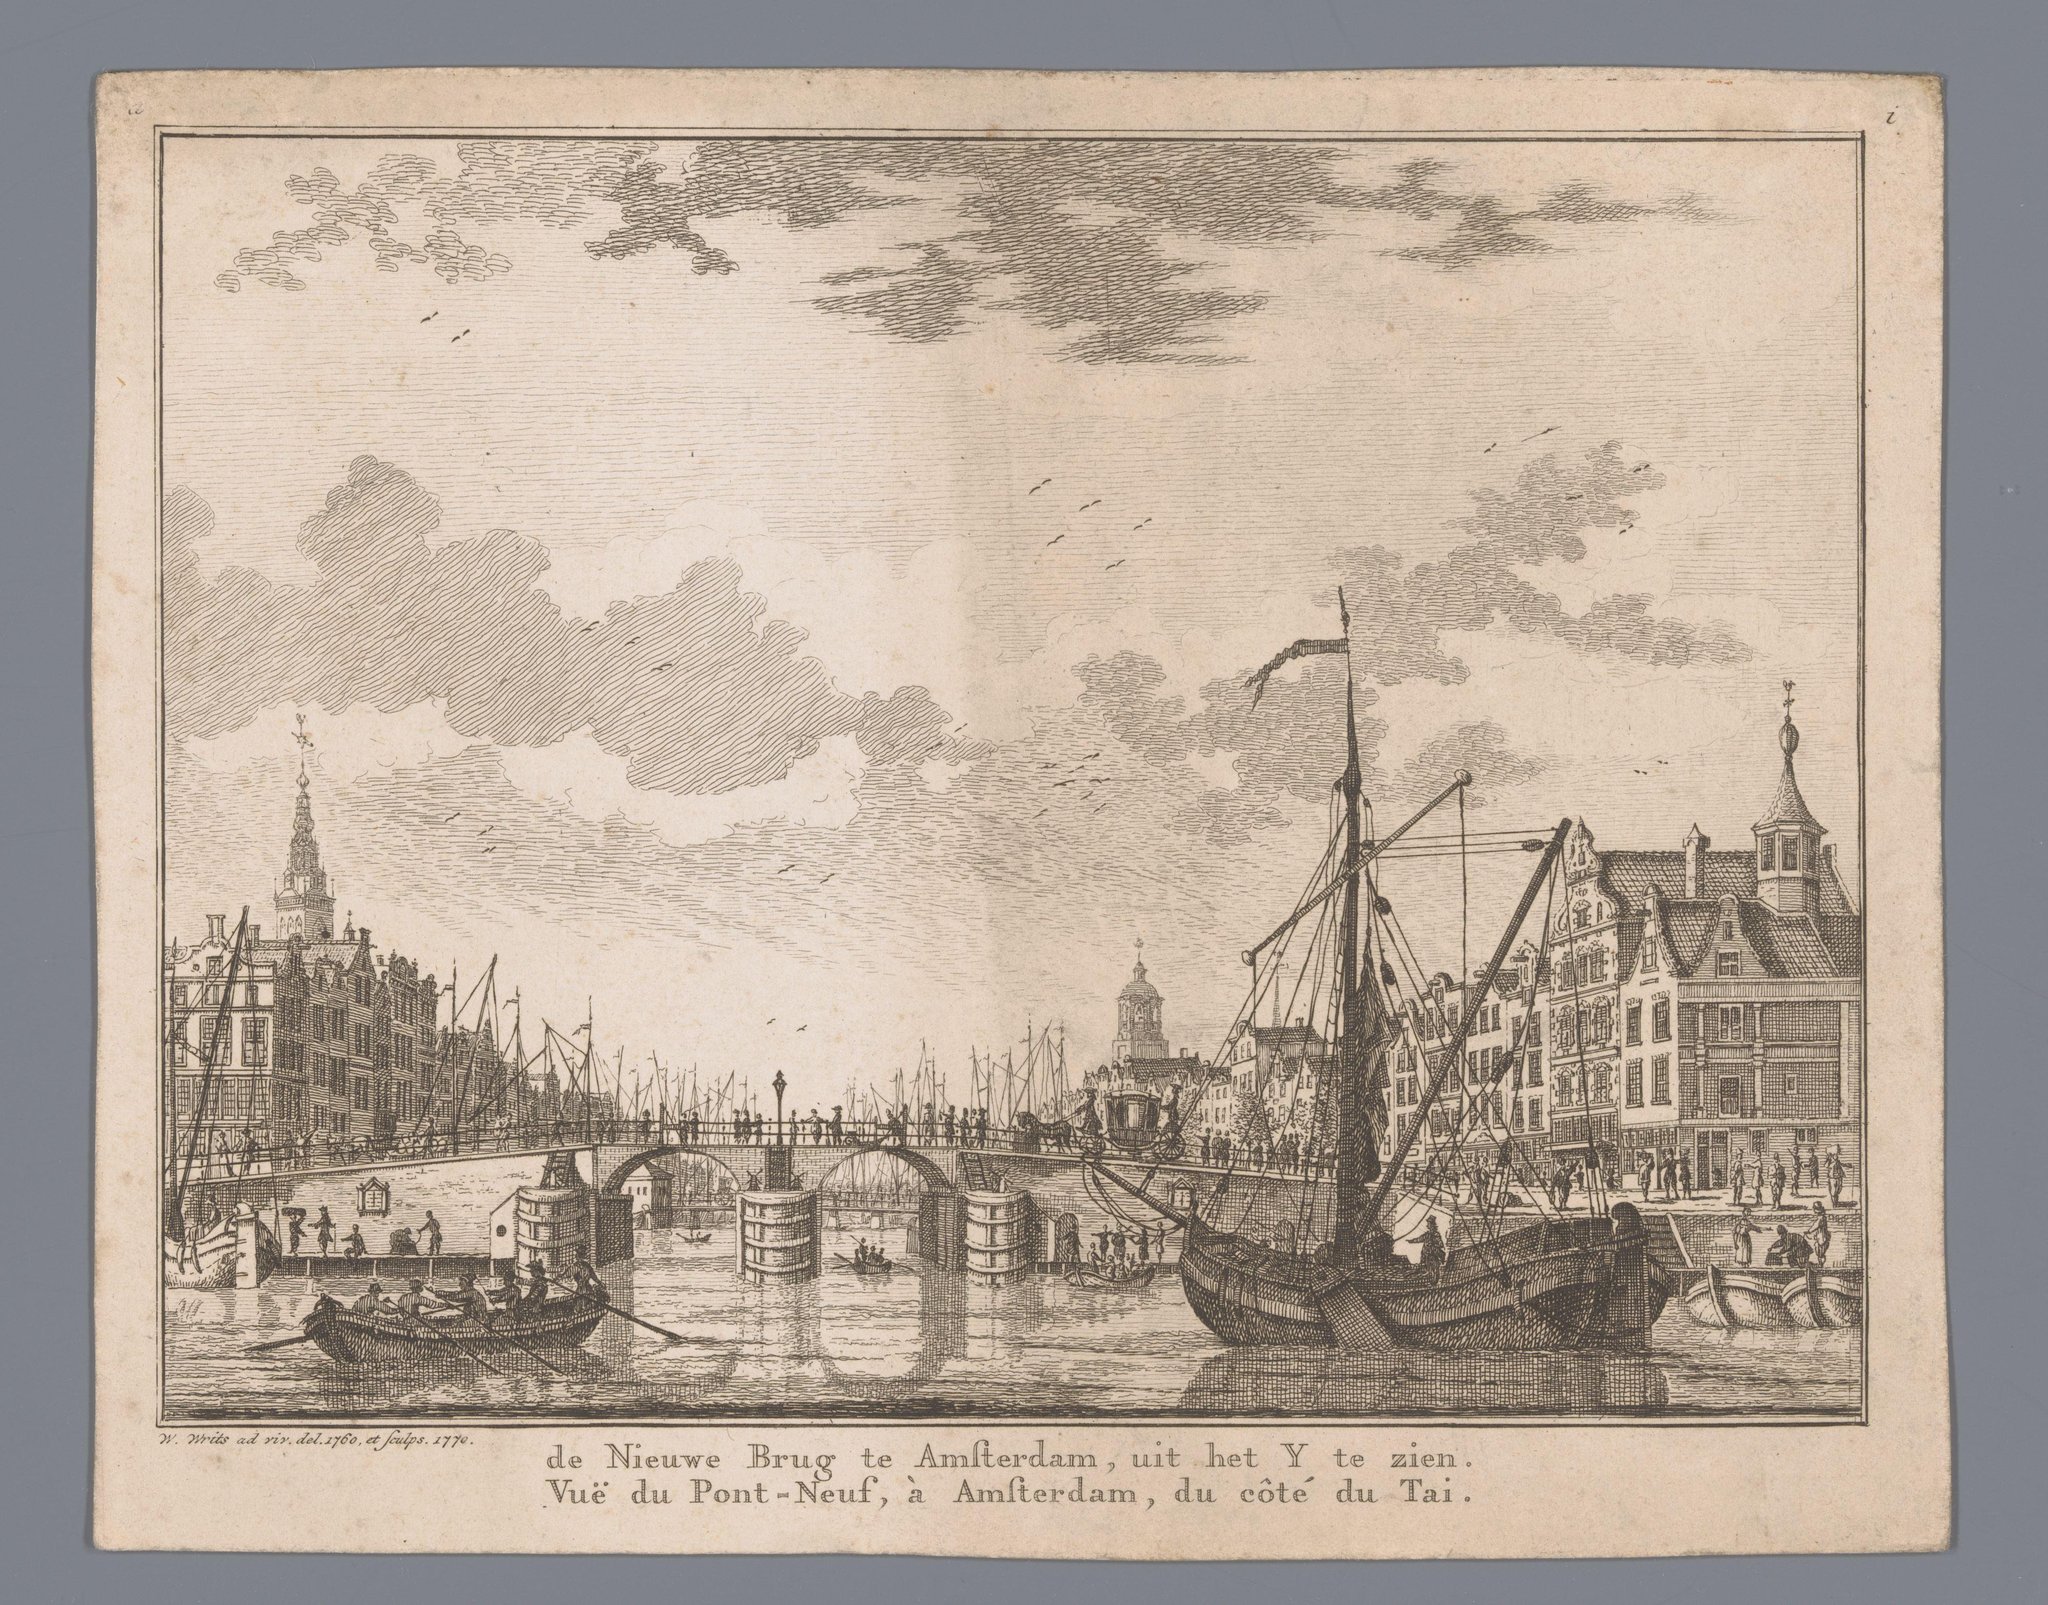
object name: print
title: Gezicht op de Nieuwe Brug en het Damrak in Amsterdam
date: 1804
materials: paper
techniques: etching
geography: amsterdam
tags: sailing-ship, sailing-boat, rowing-boat, canoe, etc., bridge in city across river, canal, etc., prospect of city, town panorama, silhouette of city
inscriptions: collector's mark: Lugt 2233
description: Prent uit: Elwe, Jan Barend. Atlas van de wereldberoemde koopstad Amsteldam (...). Amsterdam: Jan Barend Elwe, 1804.